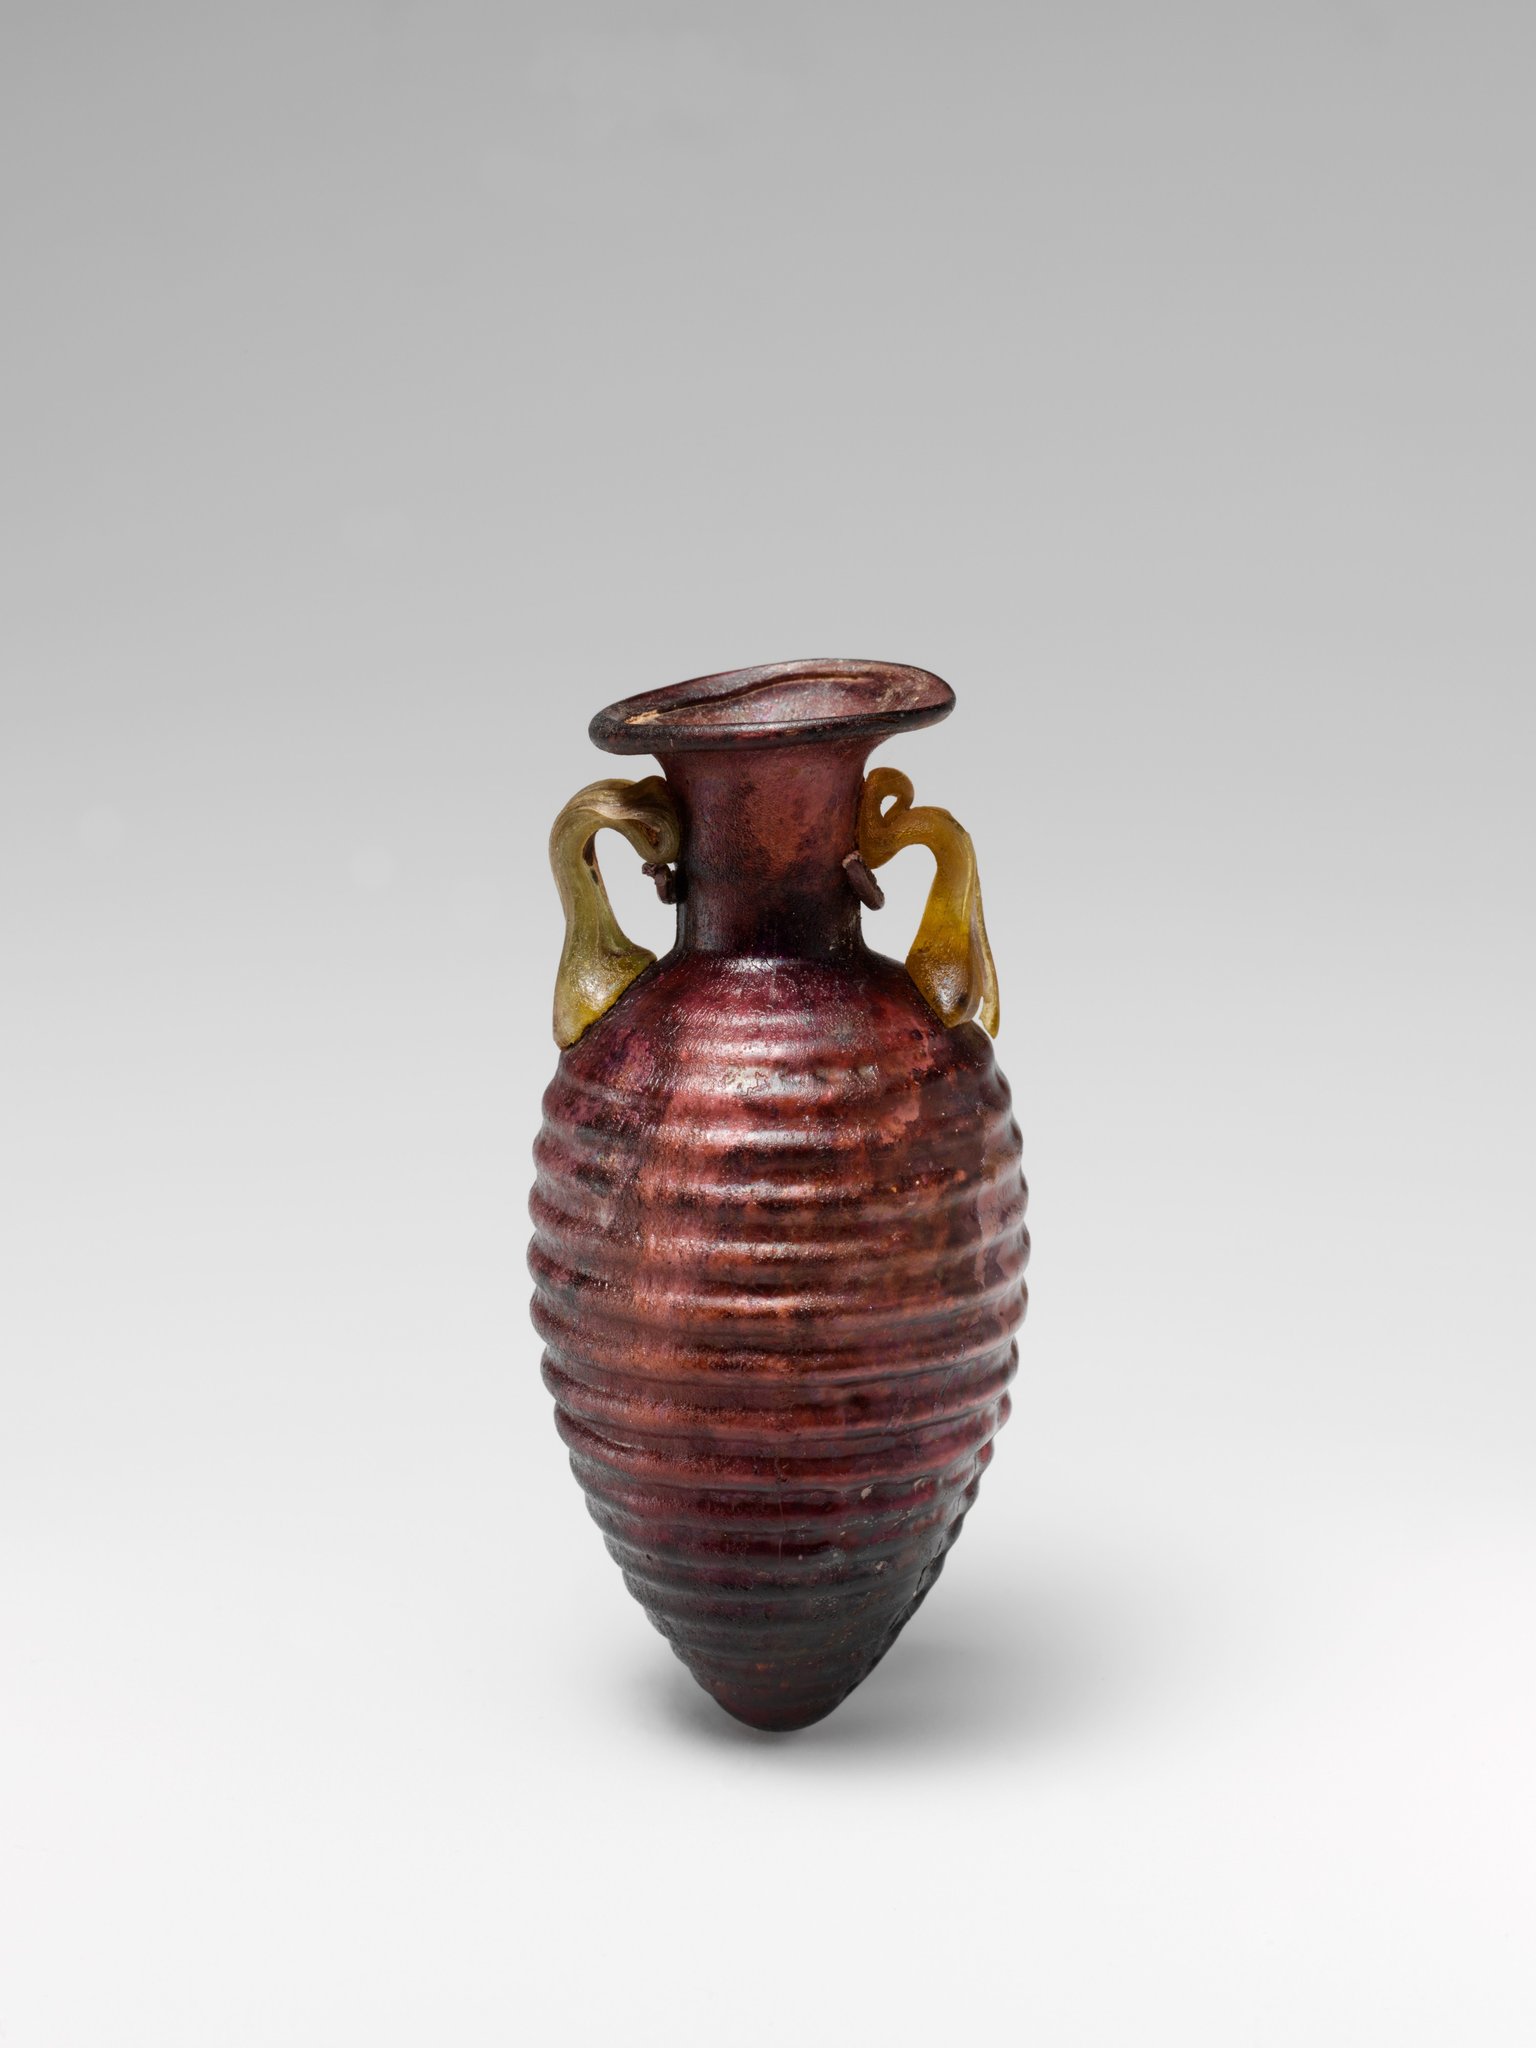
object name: miniature transport amphora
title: Glass amphoriskos with horizontal ribs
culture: roman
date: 51-100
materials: glass